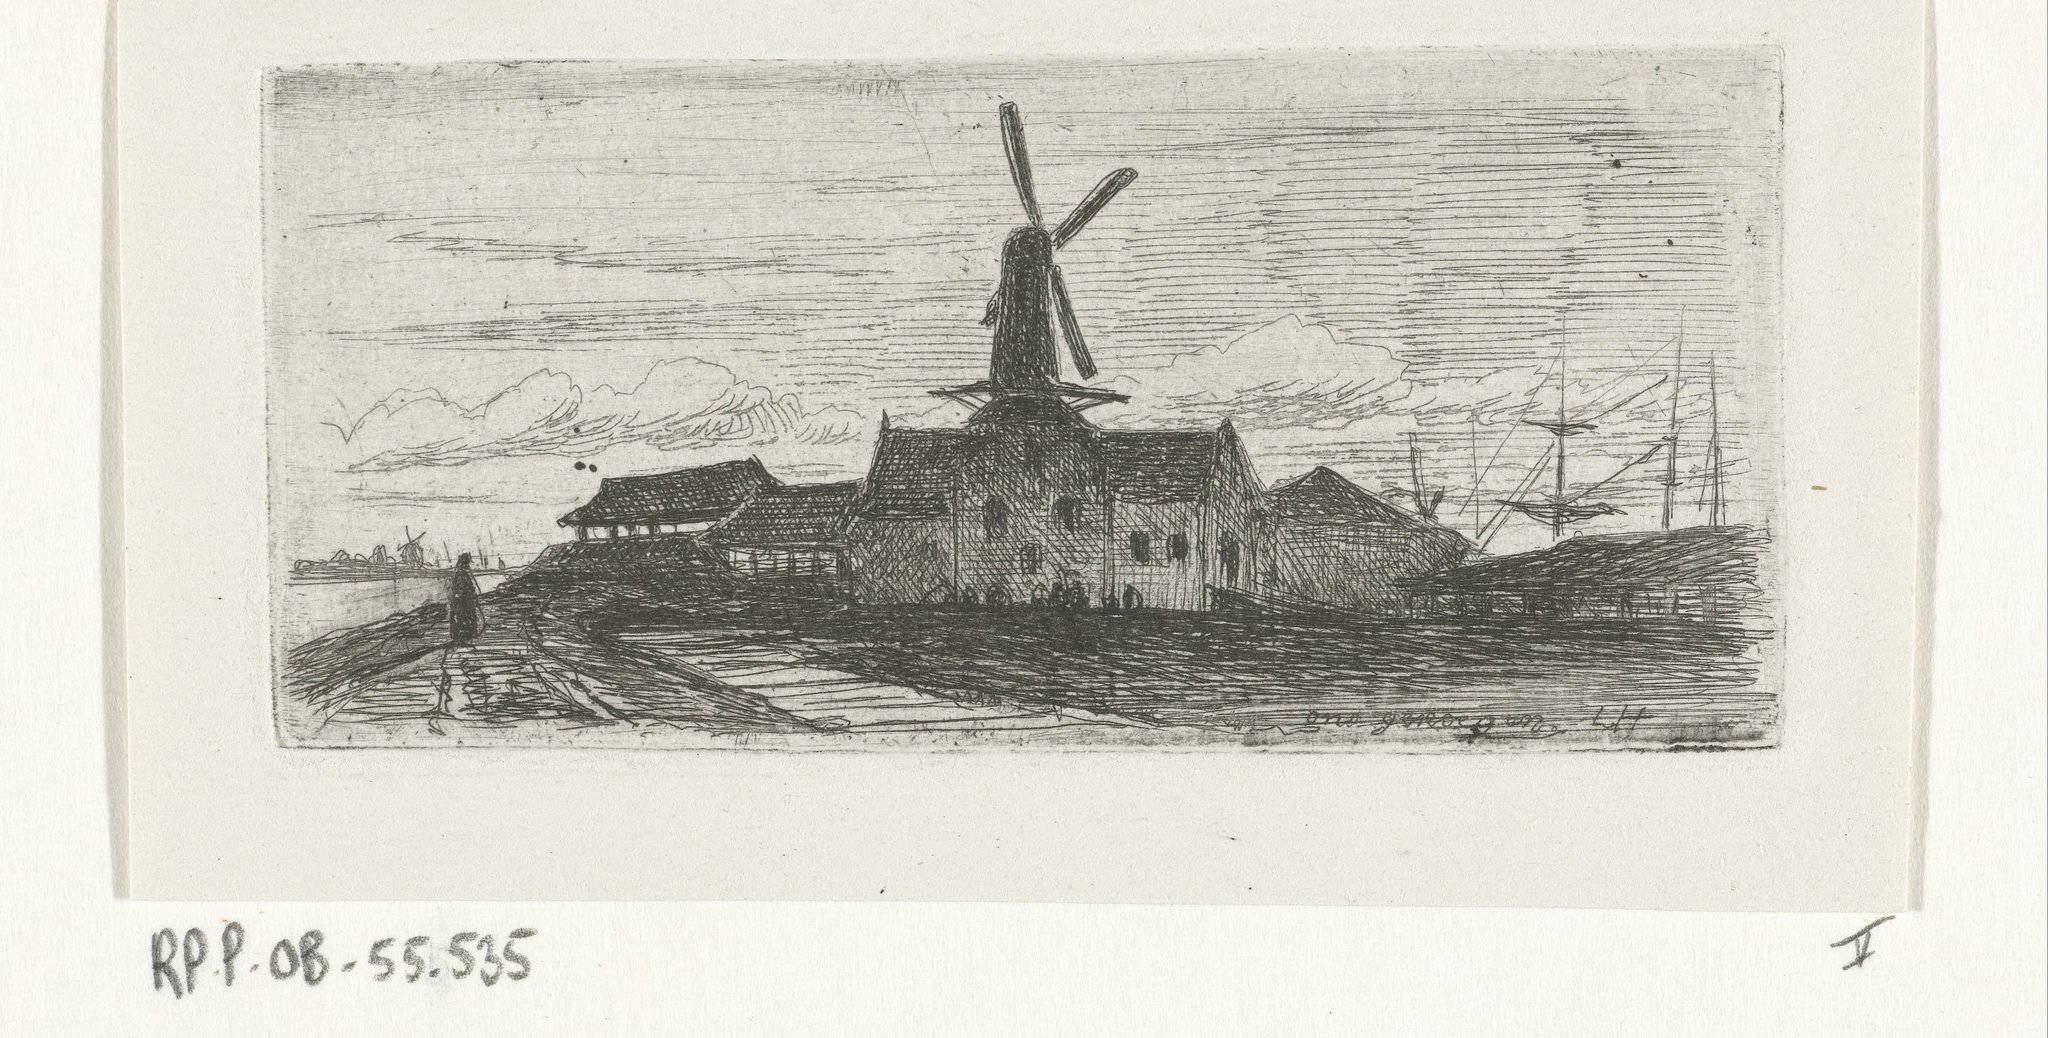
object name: print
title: Complex met molen aan een rivier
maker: lambertus hardenberg (1744)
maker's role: draughtsman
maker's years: 1744-1819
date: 1837-1900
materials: paper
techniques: etching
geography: the hague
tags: factories and mills in landscape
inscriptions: collector's mark: Lugt 2228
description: Complex met een windmolen, op een dijk, met links een wandelende figuur en rechts enkele masten zichtbaar van boten. Rechtsonder de tekst: Ons genoegen.